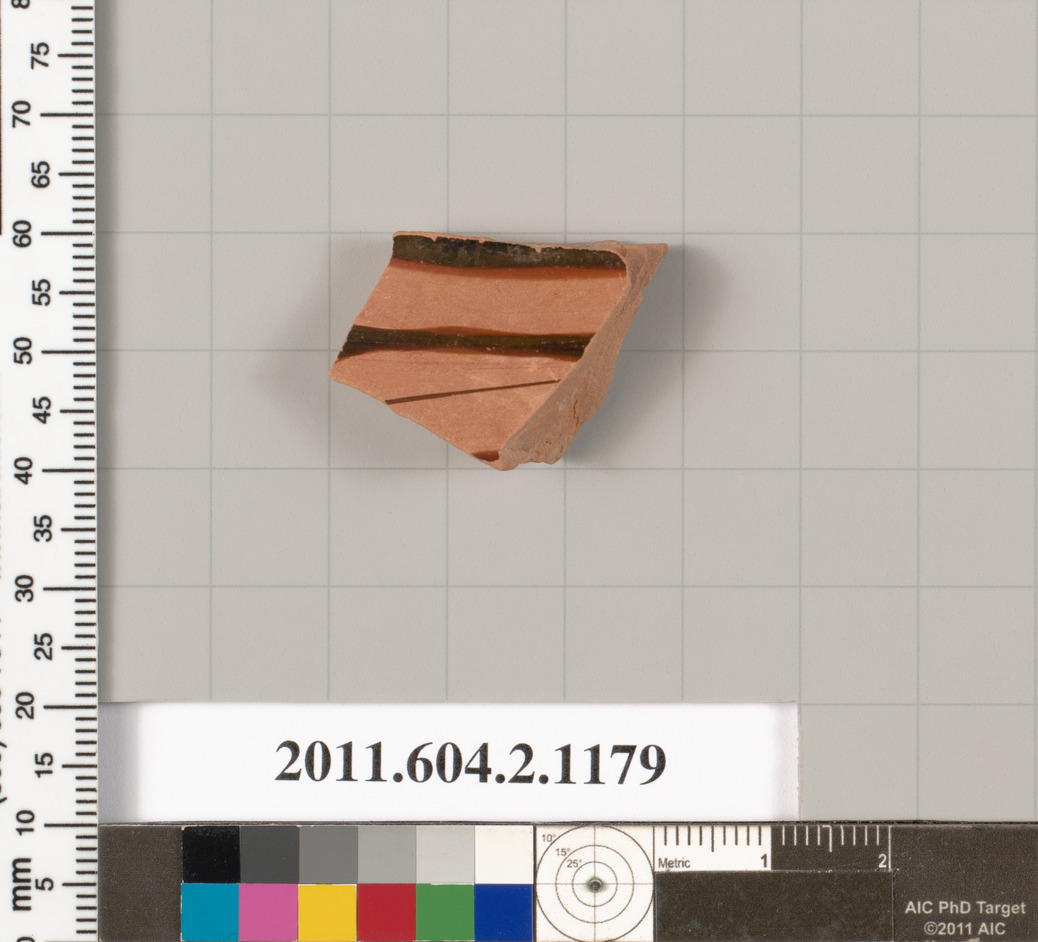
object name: bell krater fragment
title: Terracotta fragment of a bell-krater (bowl for mixing wine and water)?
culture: greek, attic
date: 450-440 BCE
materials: terracotta